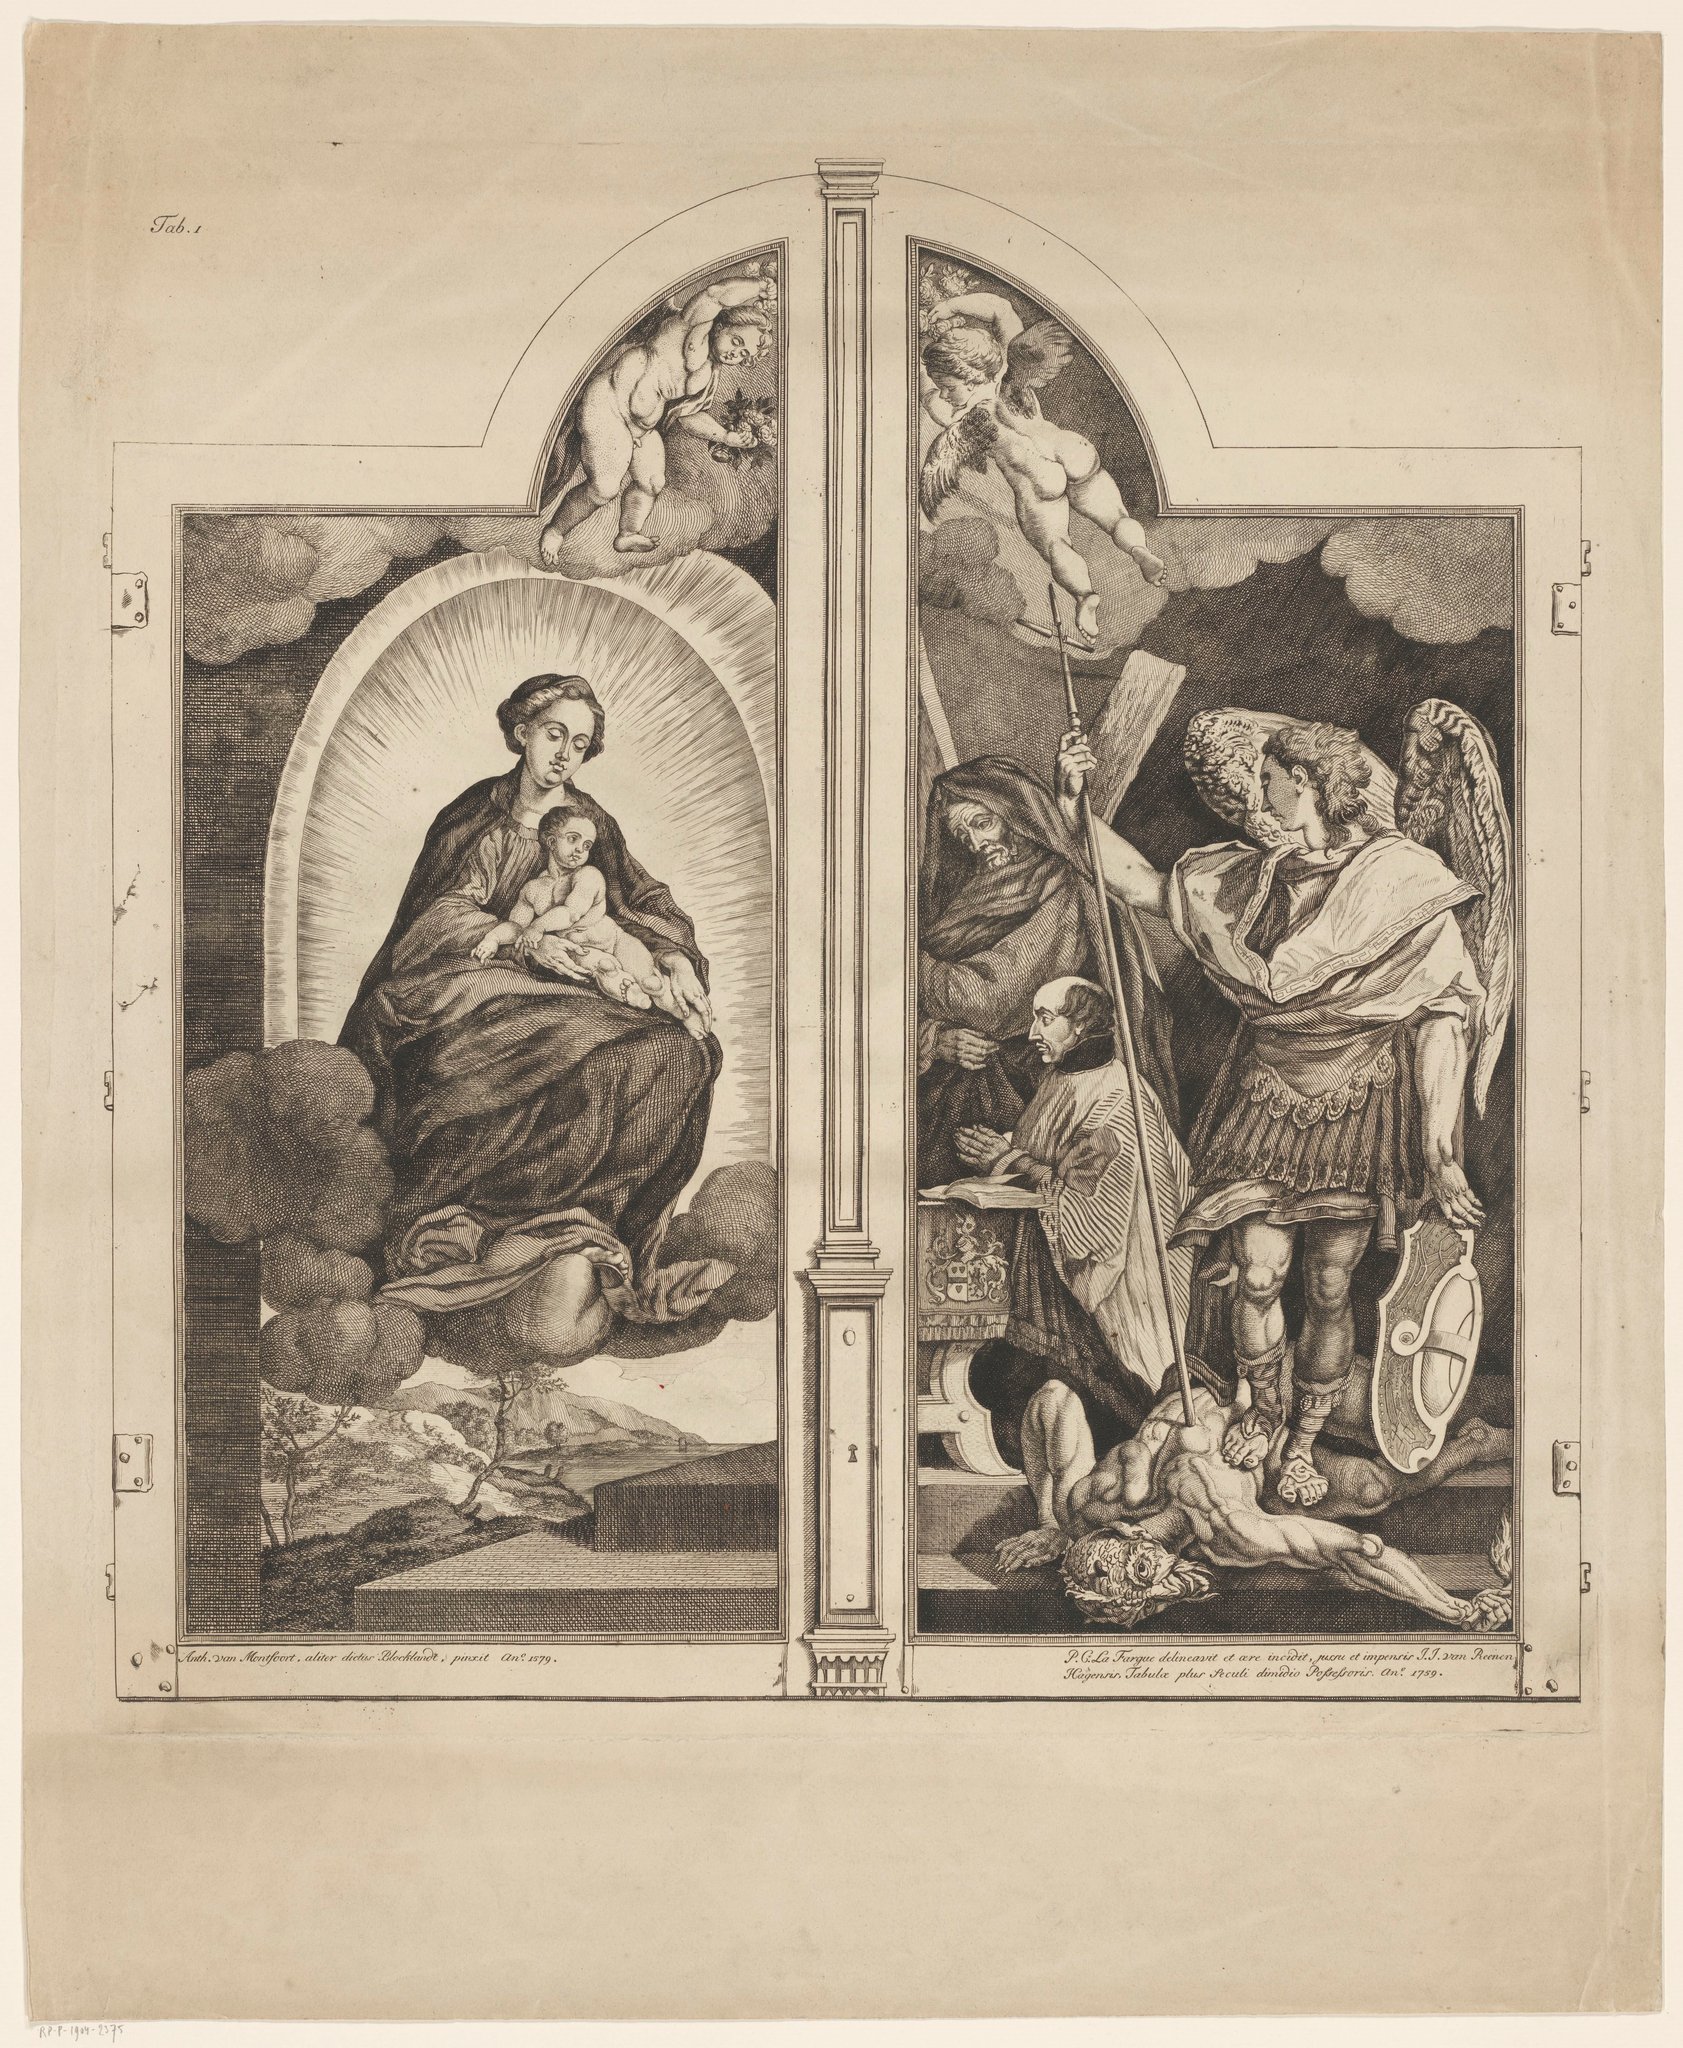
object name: print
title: Maria met kind met de opdrachtgever, de apostel Andreas en de aartsengel Michael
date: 1759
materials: paper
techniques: engraving, etching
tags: the archangel michael fighting the dragon (devil, satan), the apostle andrew; possible attributes: book, x-shaped cross, fish, fishing-net, rope, scroll, madonna (i.e. mary with the christ-child) in the air, or on the clouds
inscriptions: collector's mark: Lugt 2228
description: Onderdeel van een prent naar het drieluik naar Anthony van Blocklandt. Het middenpaneel vertoont de Hemelvaart van Maria, het linkerpaneel de Aanbidding door de herders en het rechterpaneel de Annunciatie. De achterzijden van de zijpanelen vertonen links Maria met kind en rechts de opdrachtgever met de apostel Andreas en de aartsengel Michael.